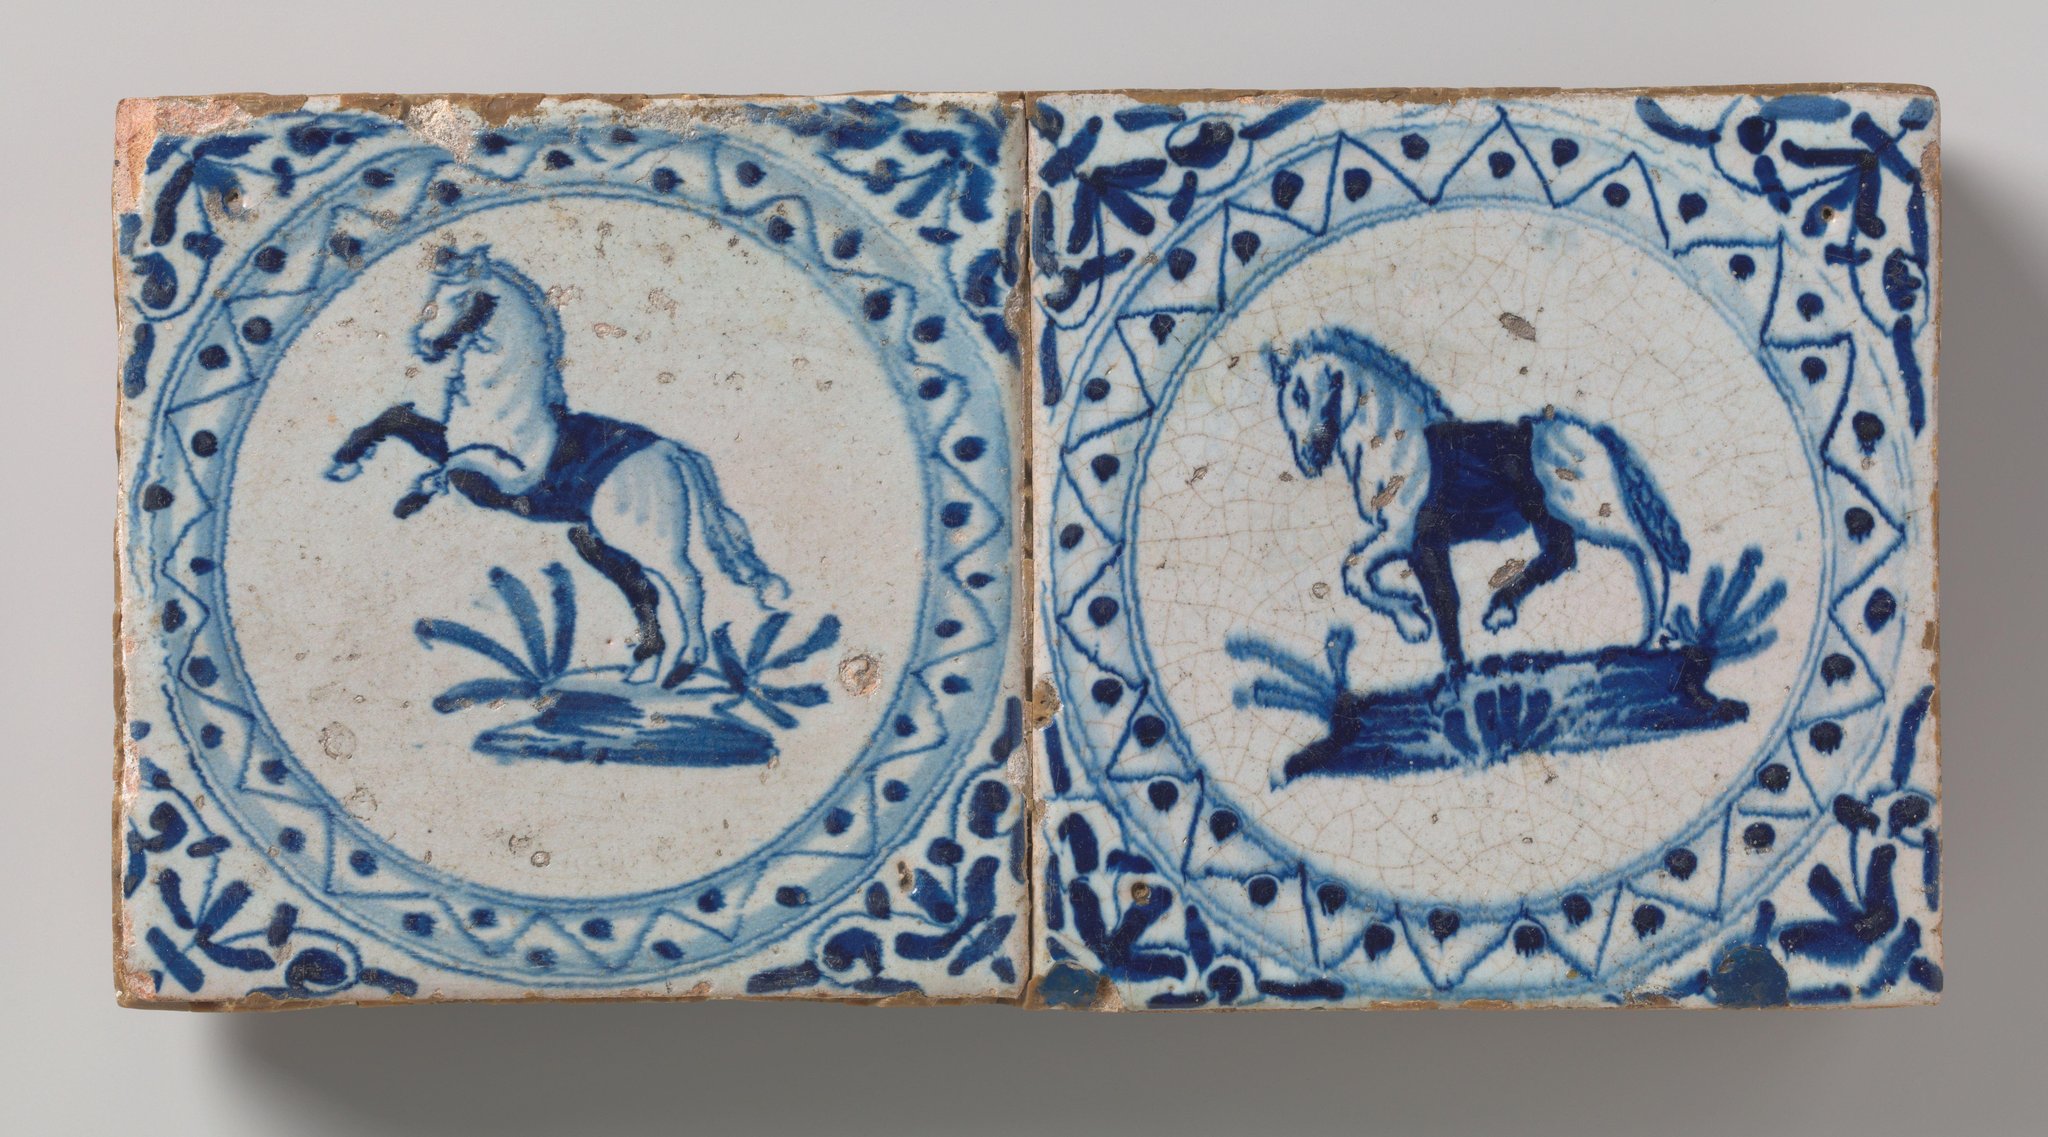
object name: tile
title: Veld van twee tegels met jager en dier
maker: Anonymous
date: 1620-1640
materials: earthenware, glaze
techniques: maiolica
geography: netherlands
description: Veld van twee tegels (1 x 2) elk met een blauw geschilderd dier of jager binnen een cirkelband met zigzag-motief. In de hoeken, een lelie.